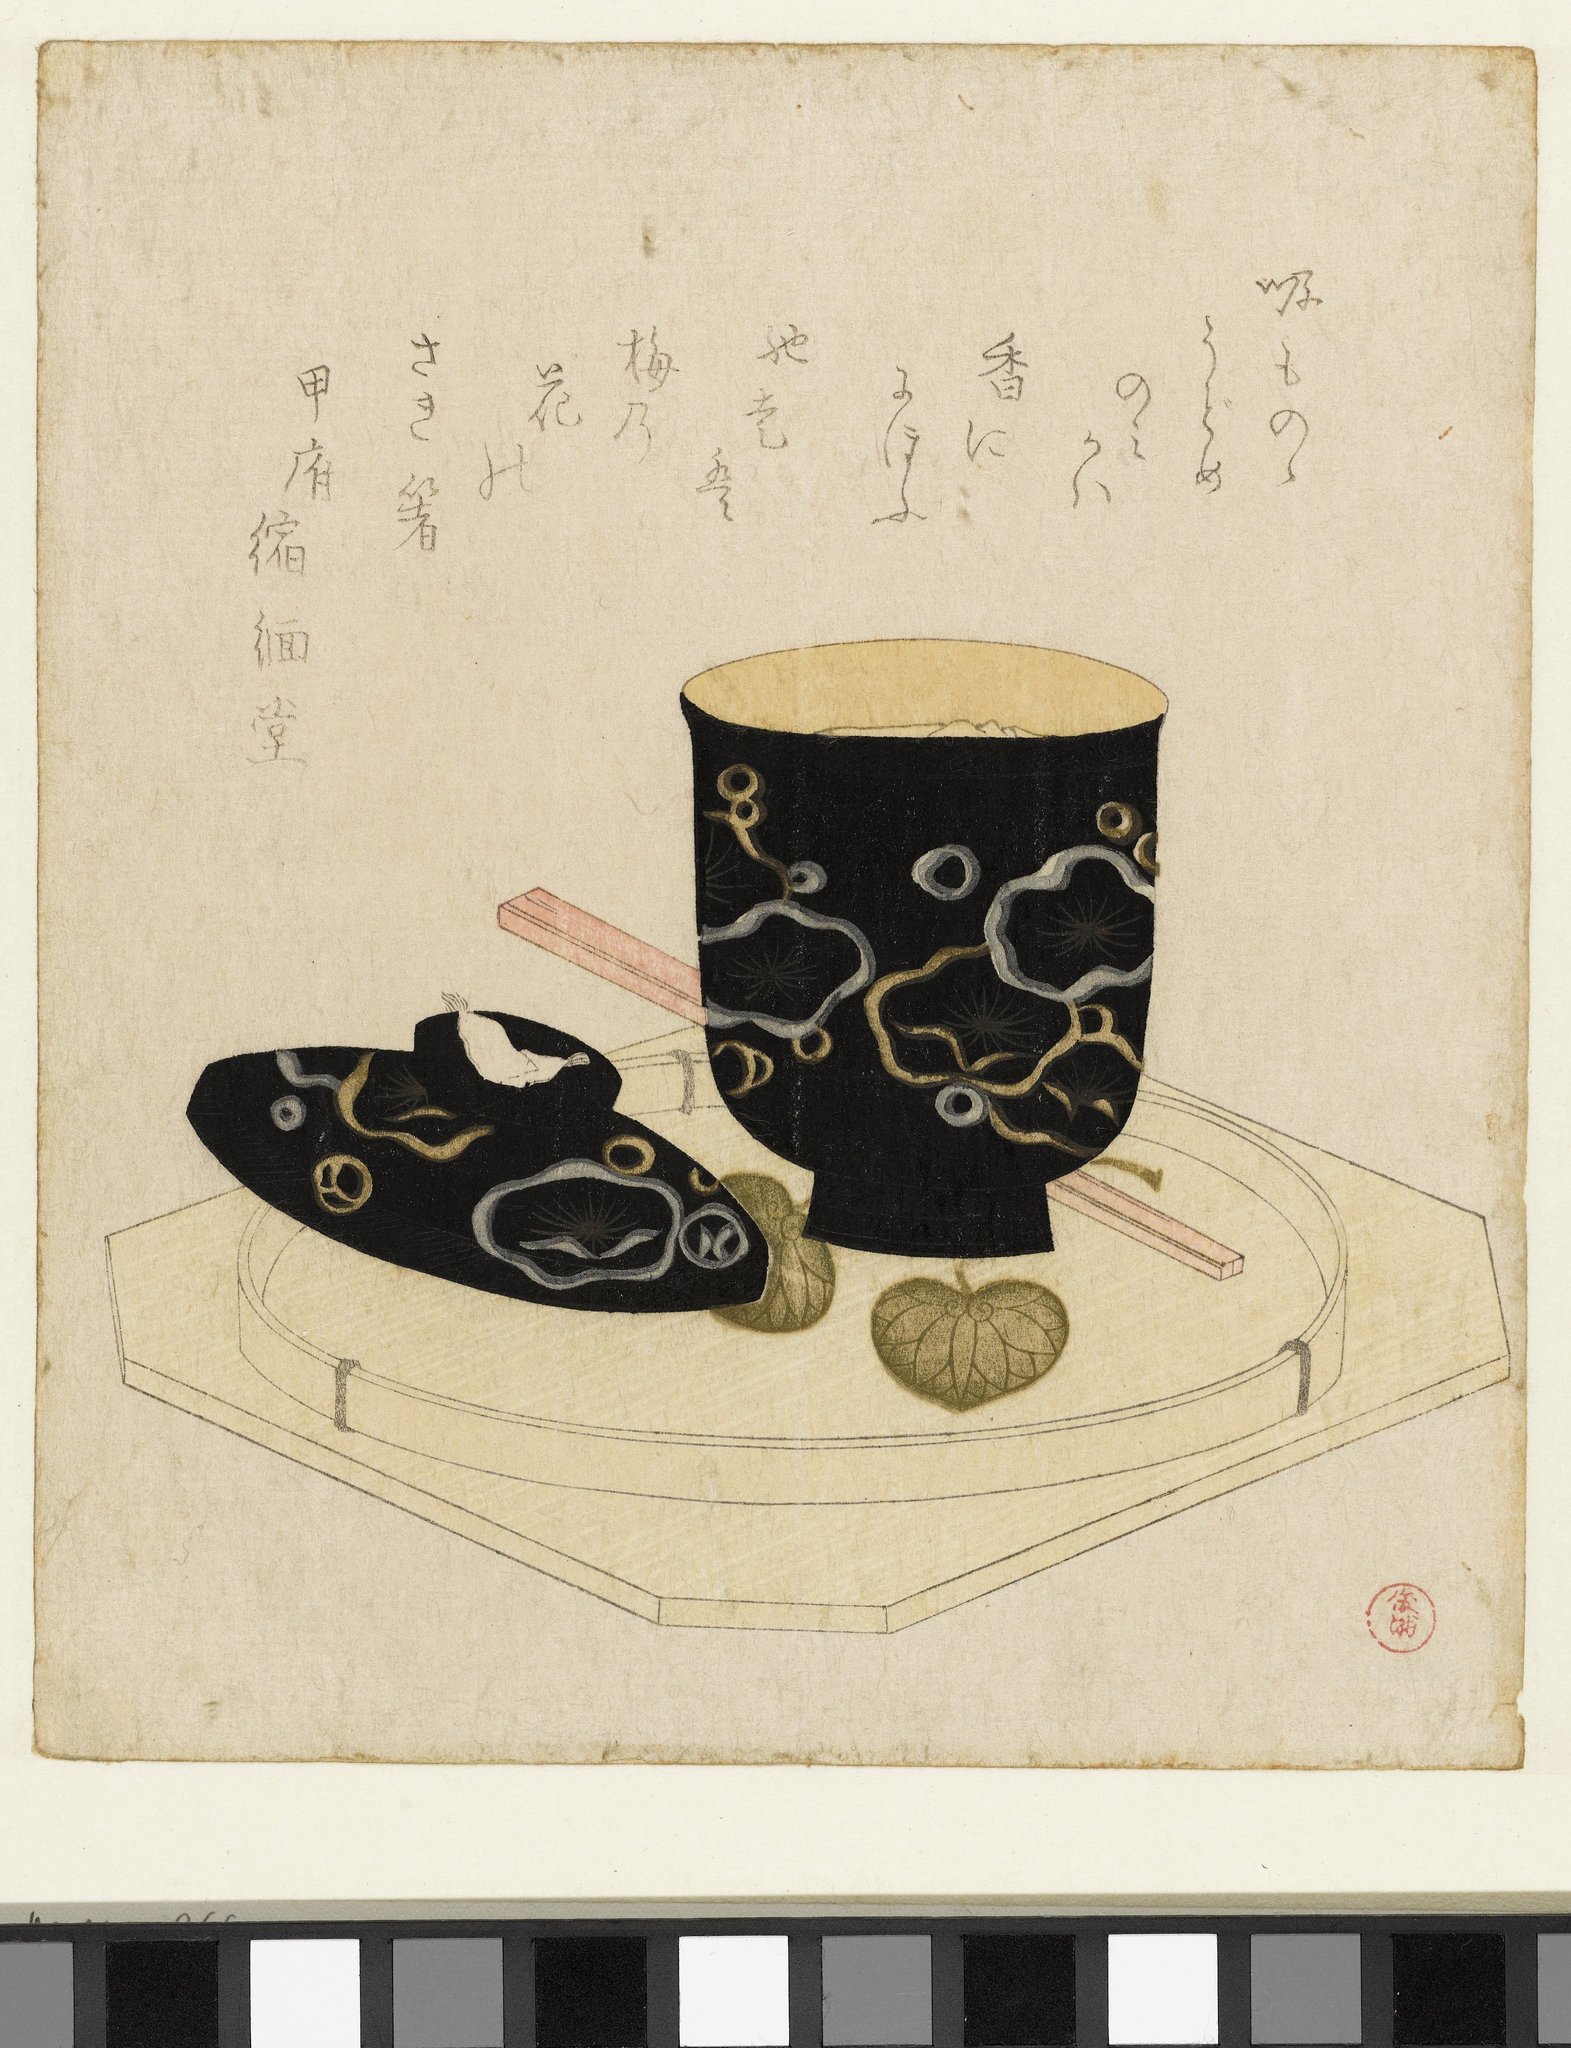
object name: surimono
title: A Lacquer Bowl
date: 1815-1820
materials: paper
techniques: blind stamped, woodcut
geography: japan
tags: bowl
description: Een surimono is een luxe uitgevoerde prent waarop beeld met één of meerdere gedichten gecombineerd is. Bij het drukken van een surimono werd vaak gebruik gemaakt van dikker papier, blinddruk en metaal pigmenten, zoals koper- en zilverpoeder. De prenten werden vaak in opdracht van dichters gemaakt en als exclusief geschenk aan vrienden en relaties gegeven.